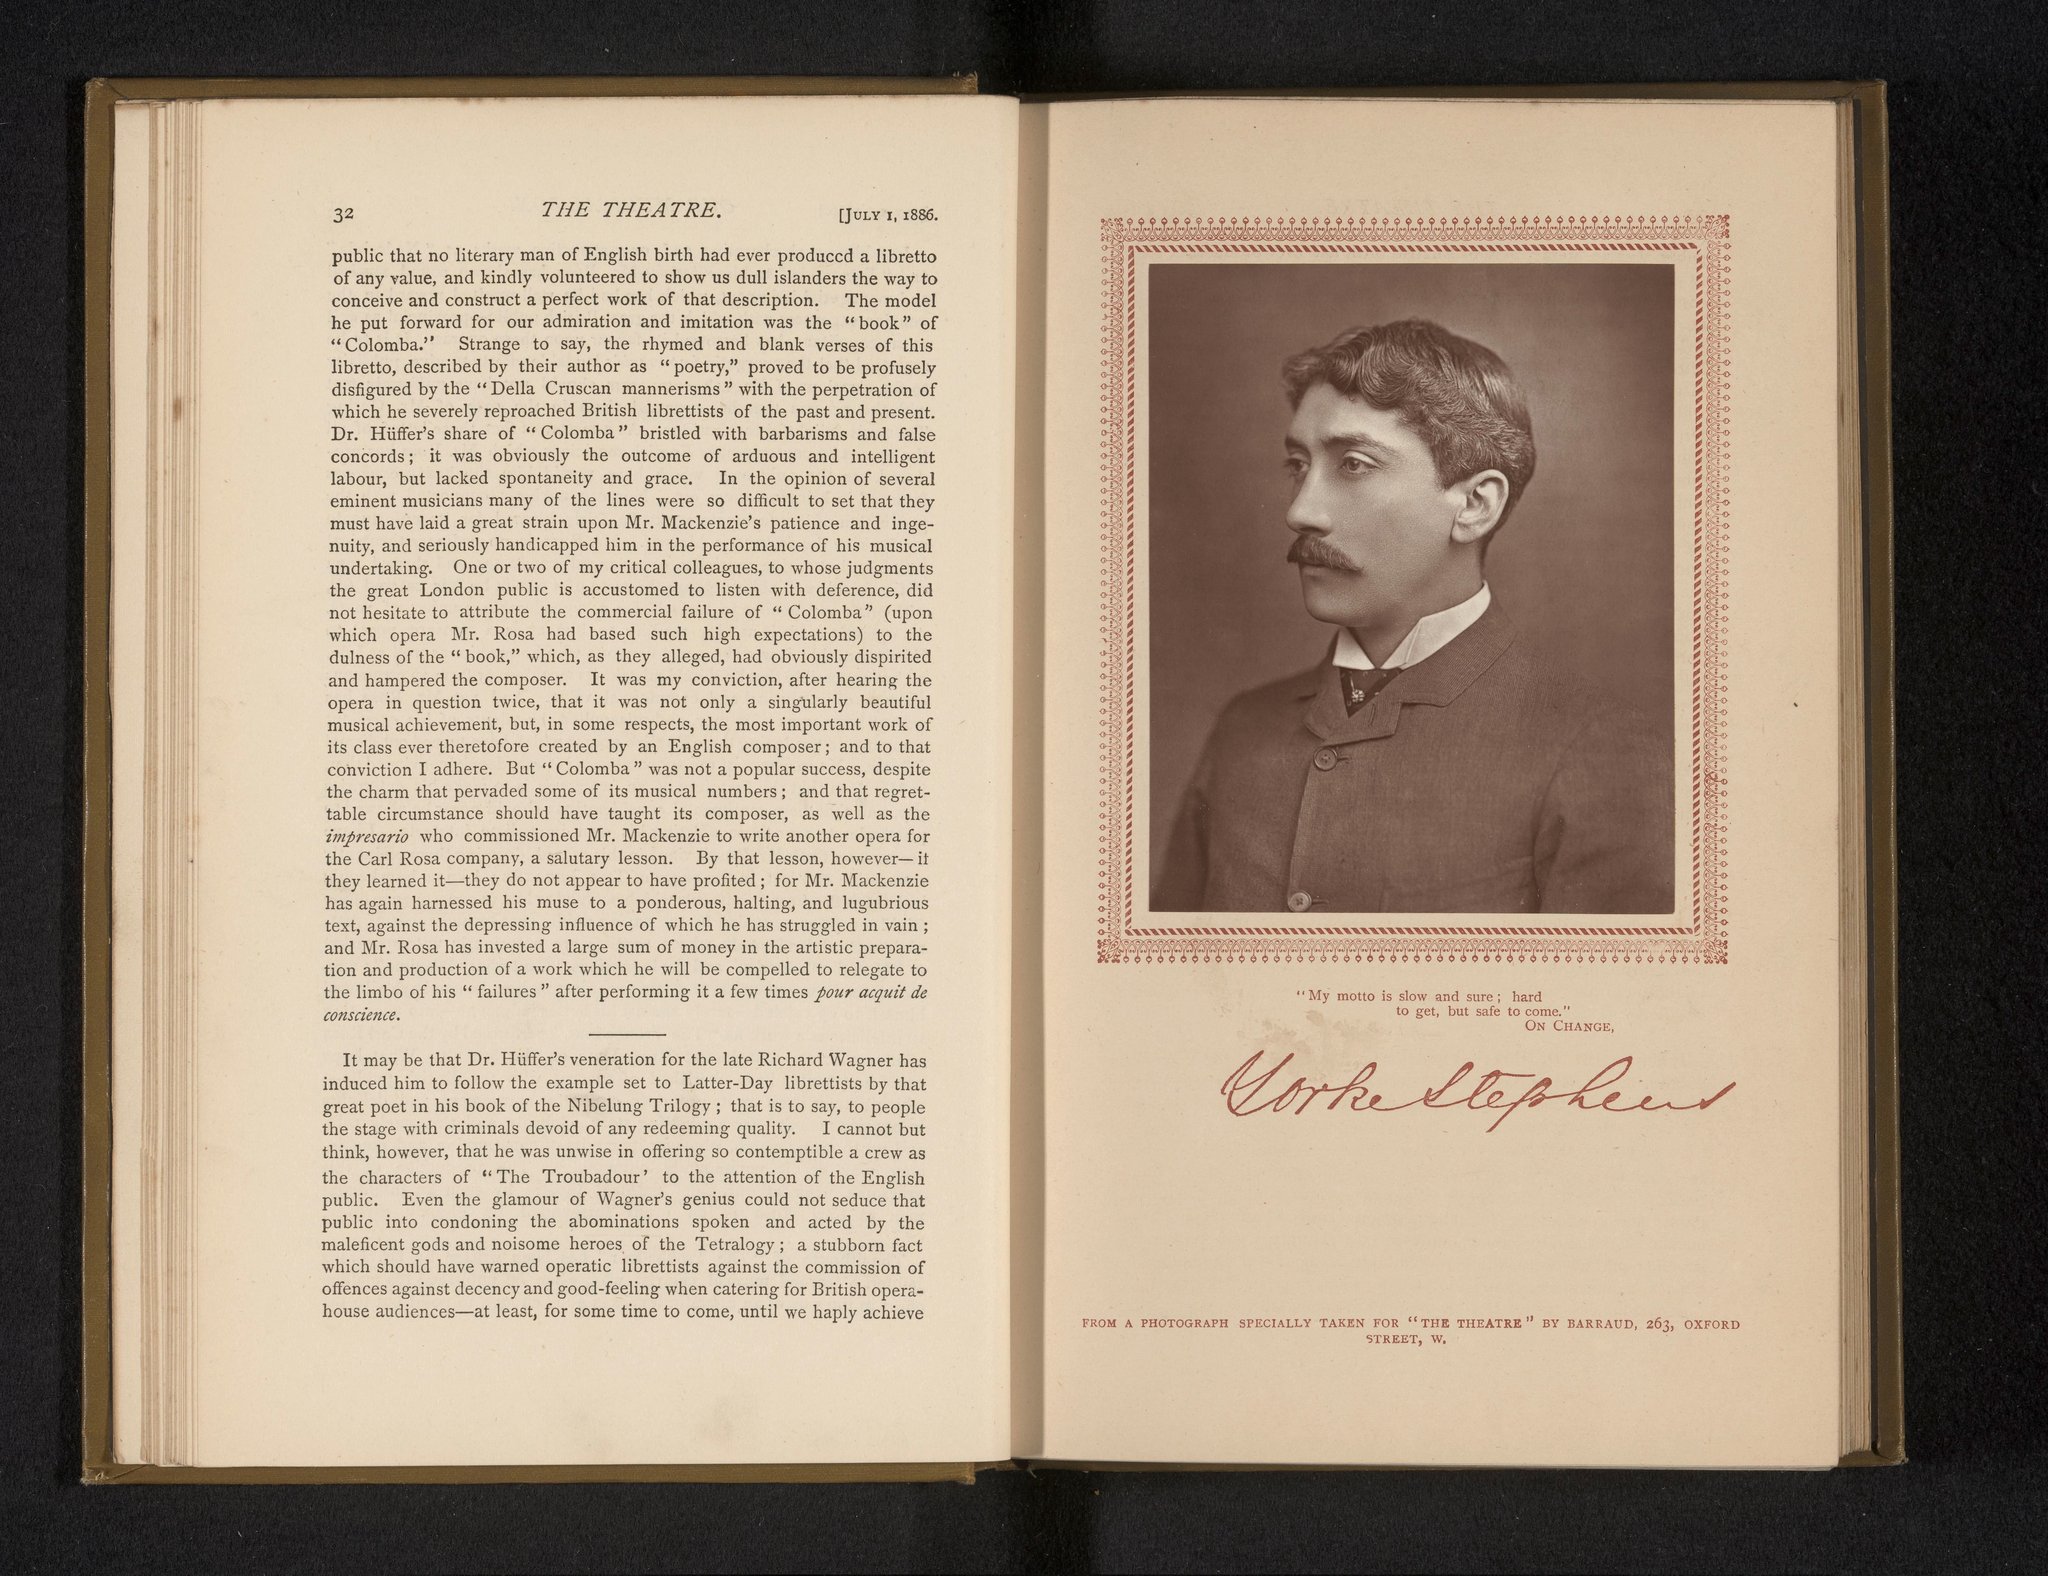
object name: photomechanical print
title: Portret van Yorke Stephens in 'On Change'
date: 1881-1886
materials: paper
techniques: woodburytype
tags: adult man, historical persons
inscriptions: inscription: ‘'My motto is slow and sure; hard/ to get, but safe to come.'/ On Change’, signature: ‘Yorke Stephens’